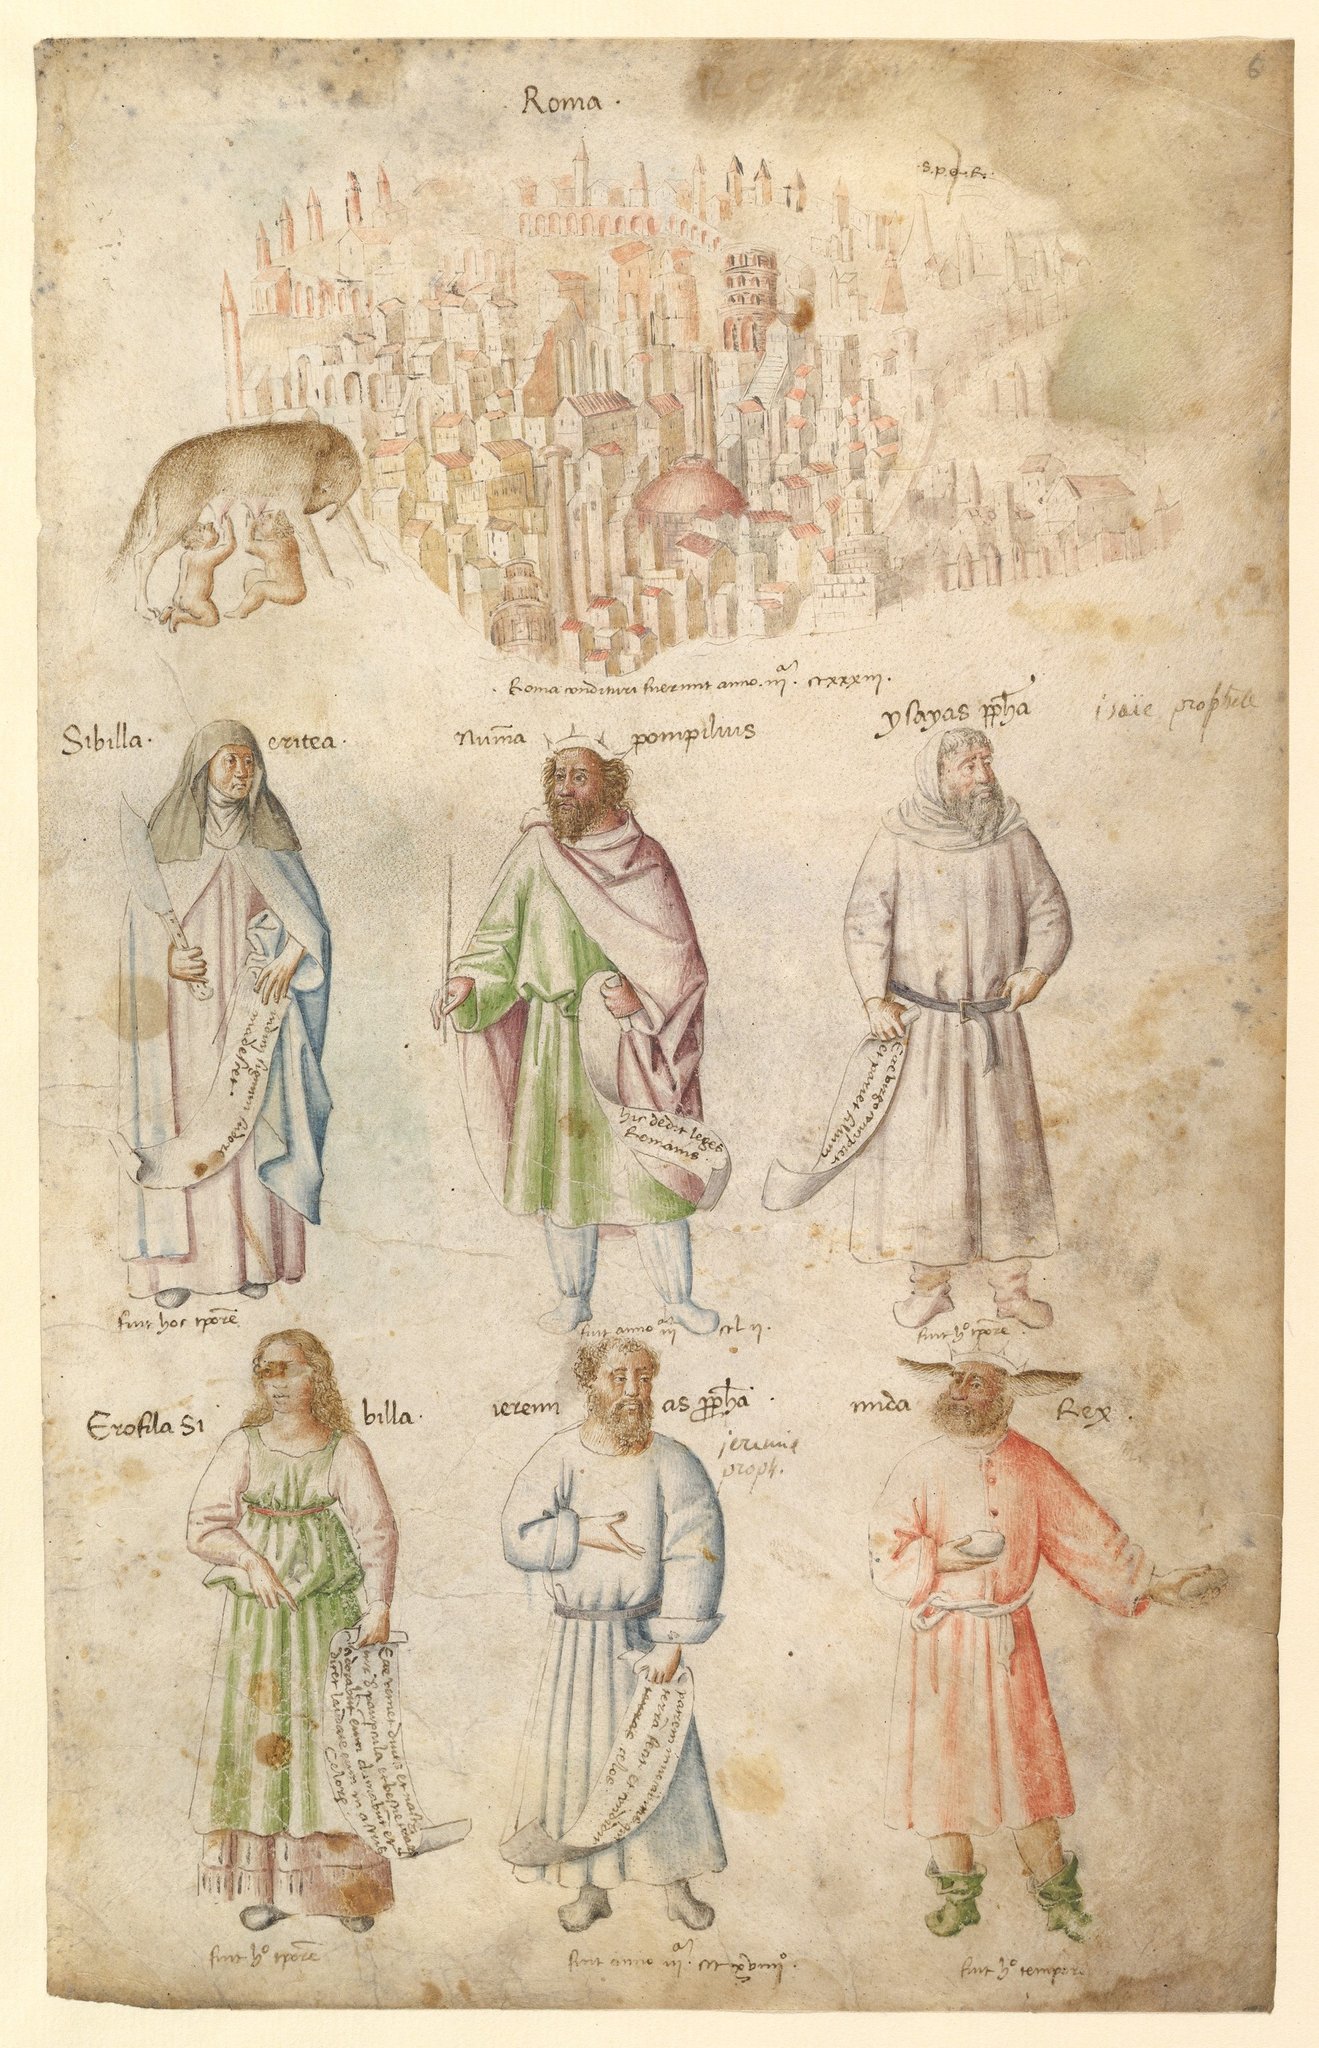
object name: drawing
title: Famous Men and Women from Classical and Biblical Antiquity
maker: barthelemy d'eyck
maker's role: artist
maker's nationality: netherlandish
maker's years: 1444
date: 1450-1459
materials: ink, watercolor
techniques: brush, pen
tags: cities,men,women